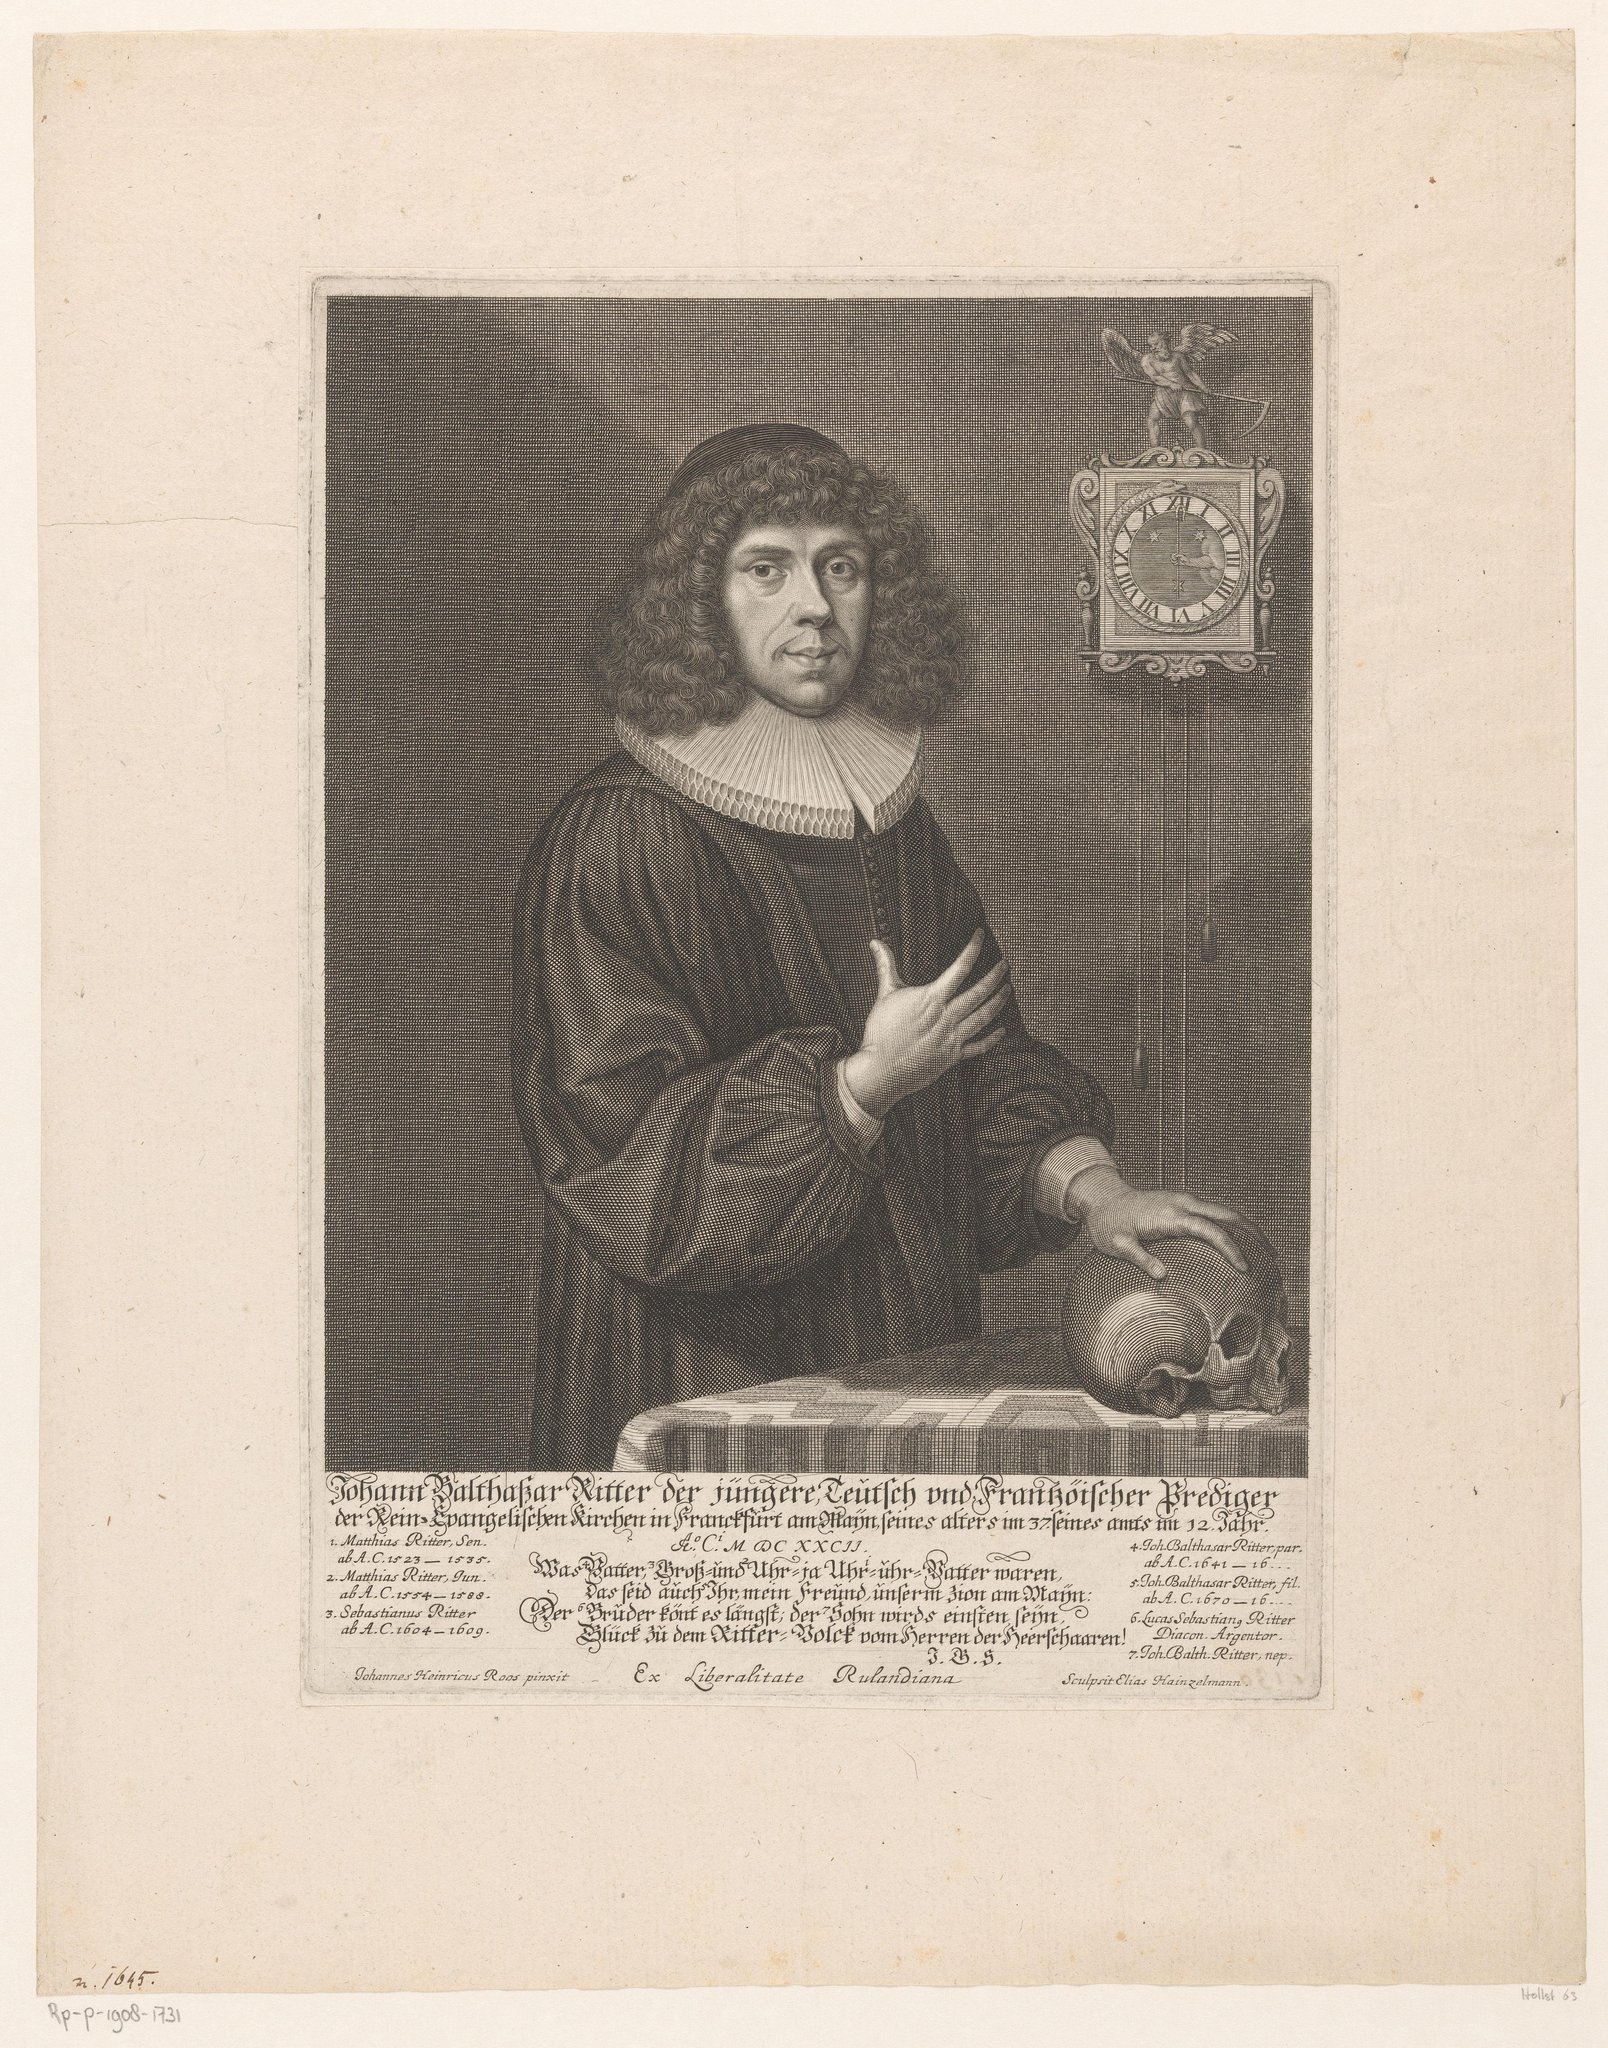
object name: print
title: Portret van Johann Balthasar Ritter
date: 1654-1693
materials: paper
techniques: engraving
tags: historical persons, clock, meditation over skull and/or crucifix, father time, man with wings and scythe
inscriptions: inscription, collector's mark: Lugt 2228